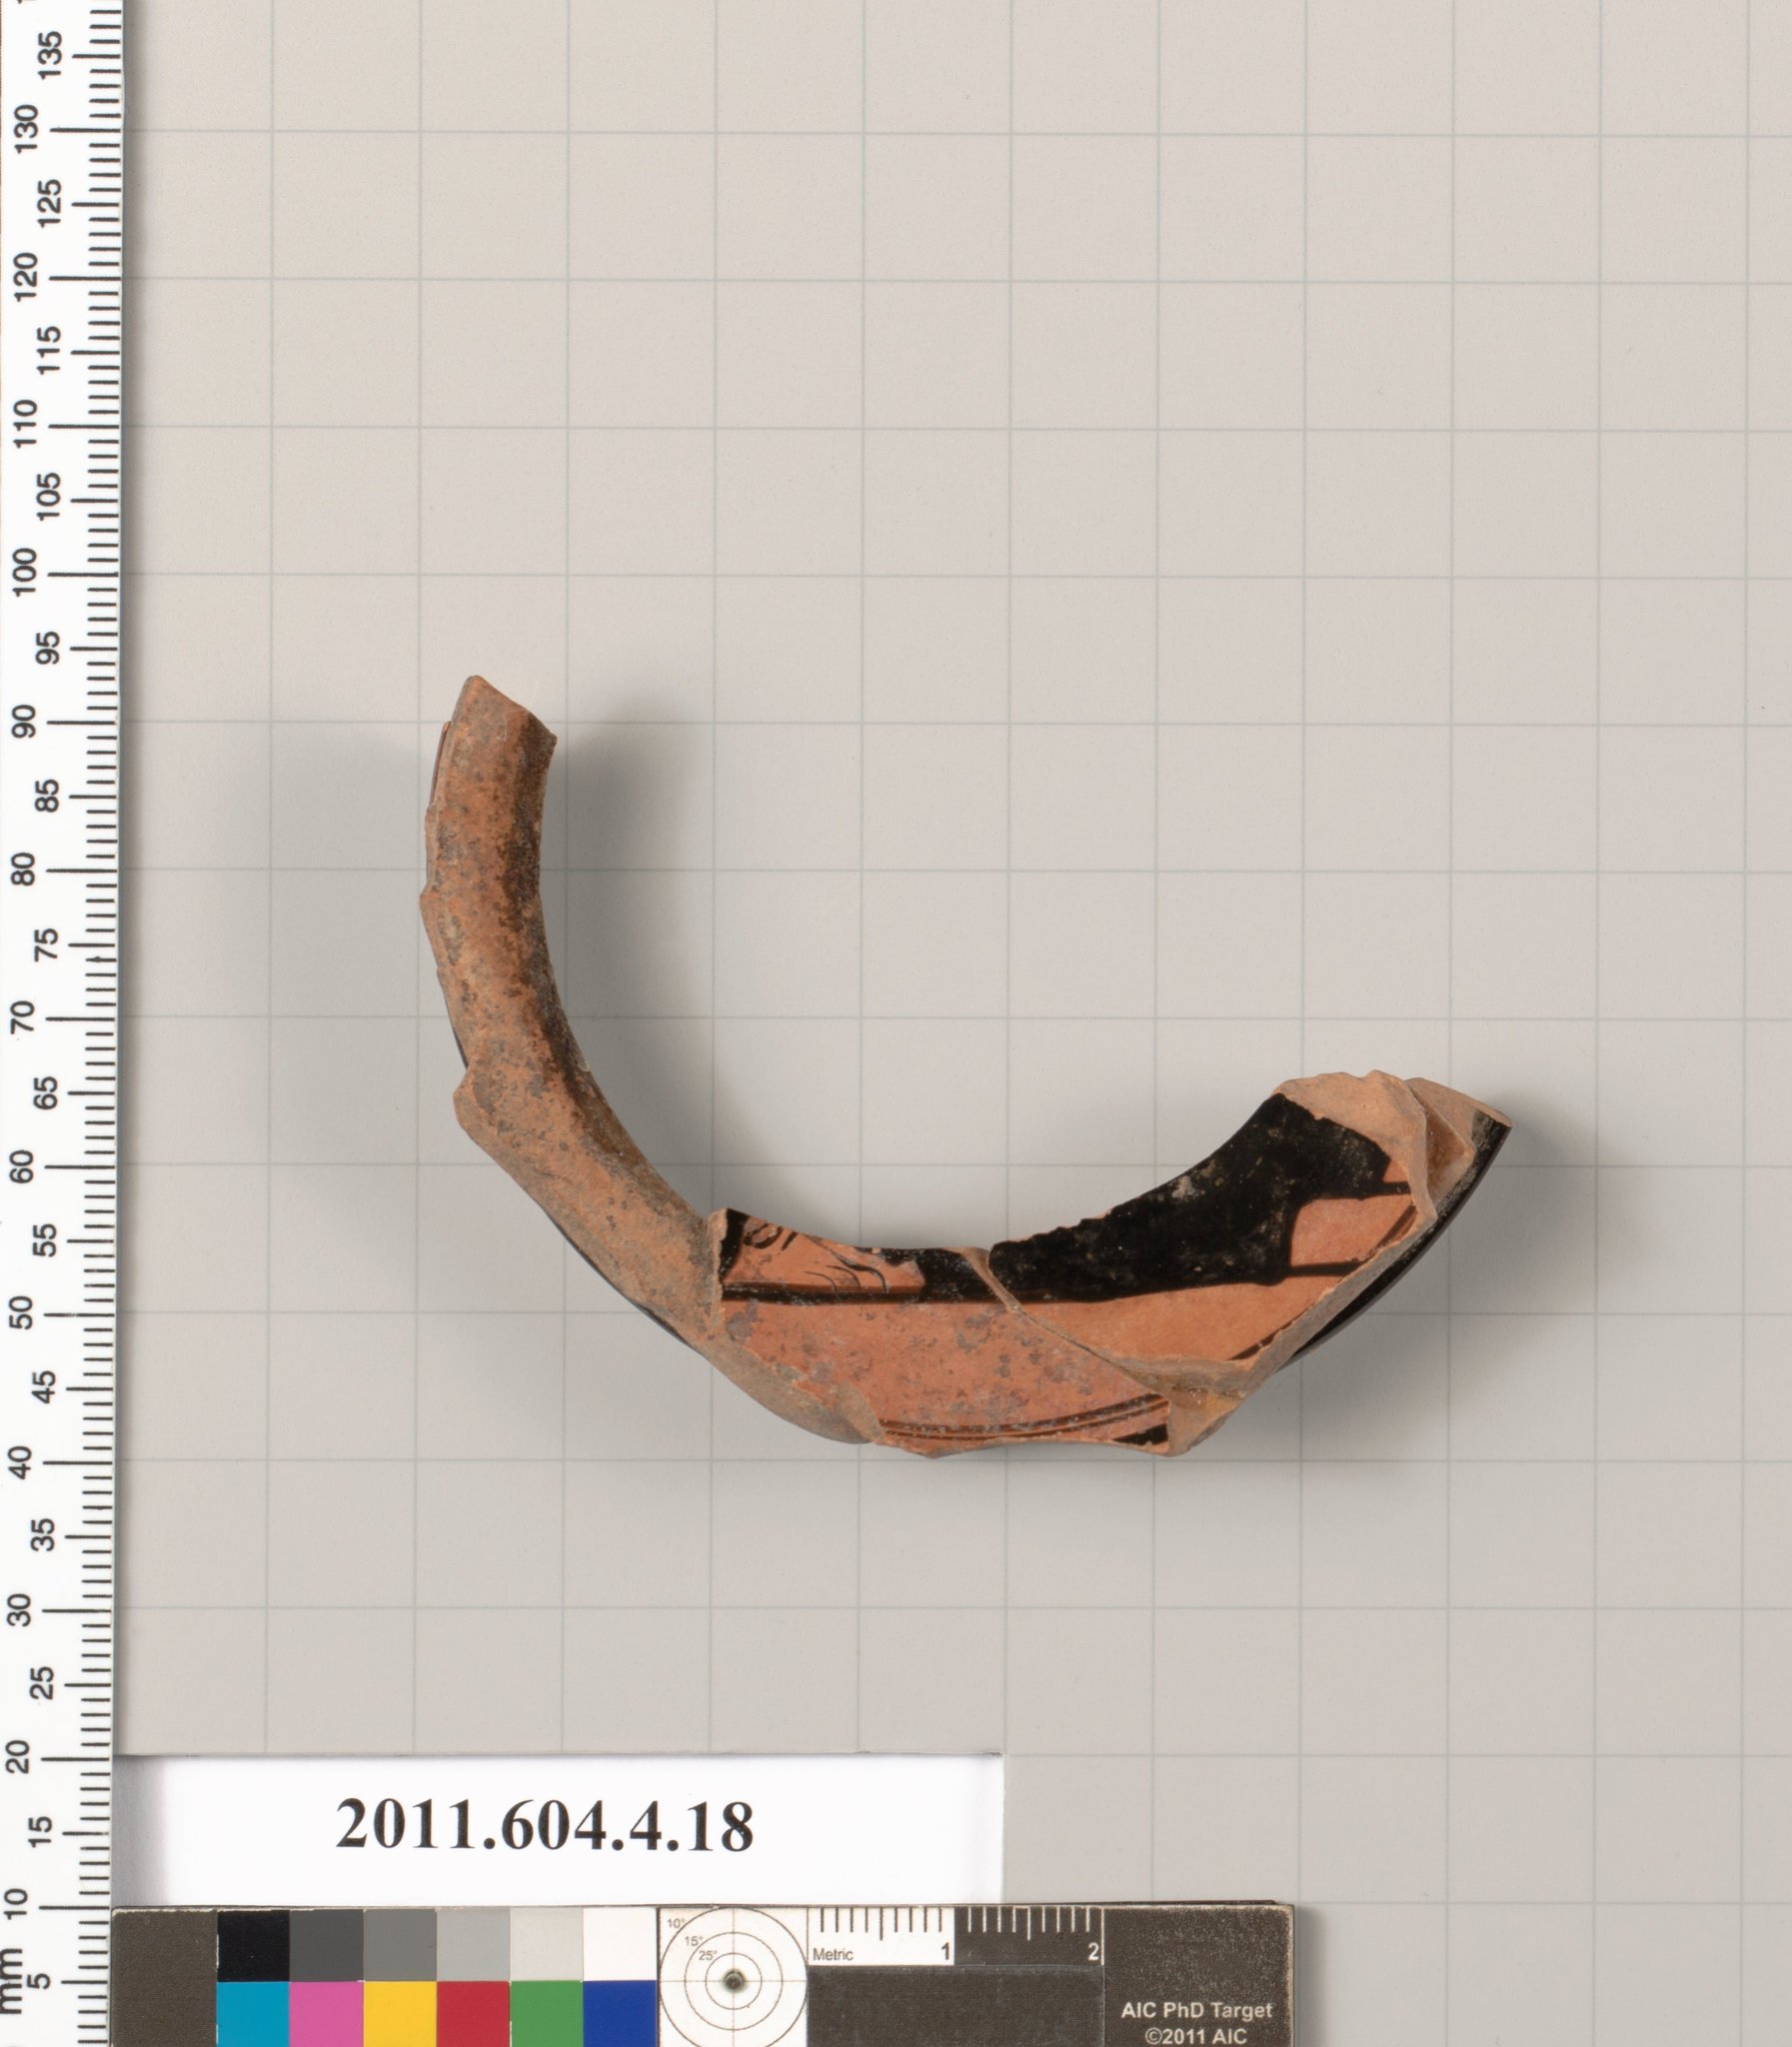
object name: kylix fragment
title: Terracotta fragment of a stemless kylix (drinking cup)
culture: greek, attic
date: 450-426 BCE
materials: terracotta